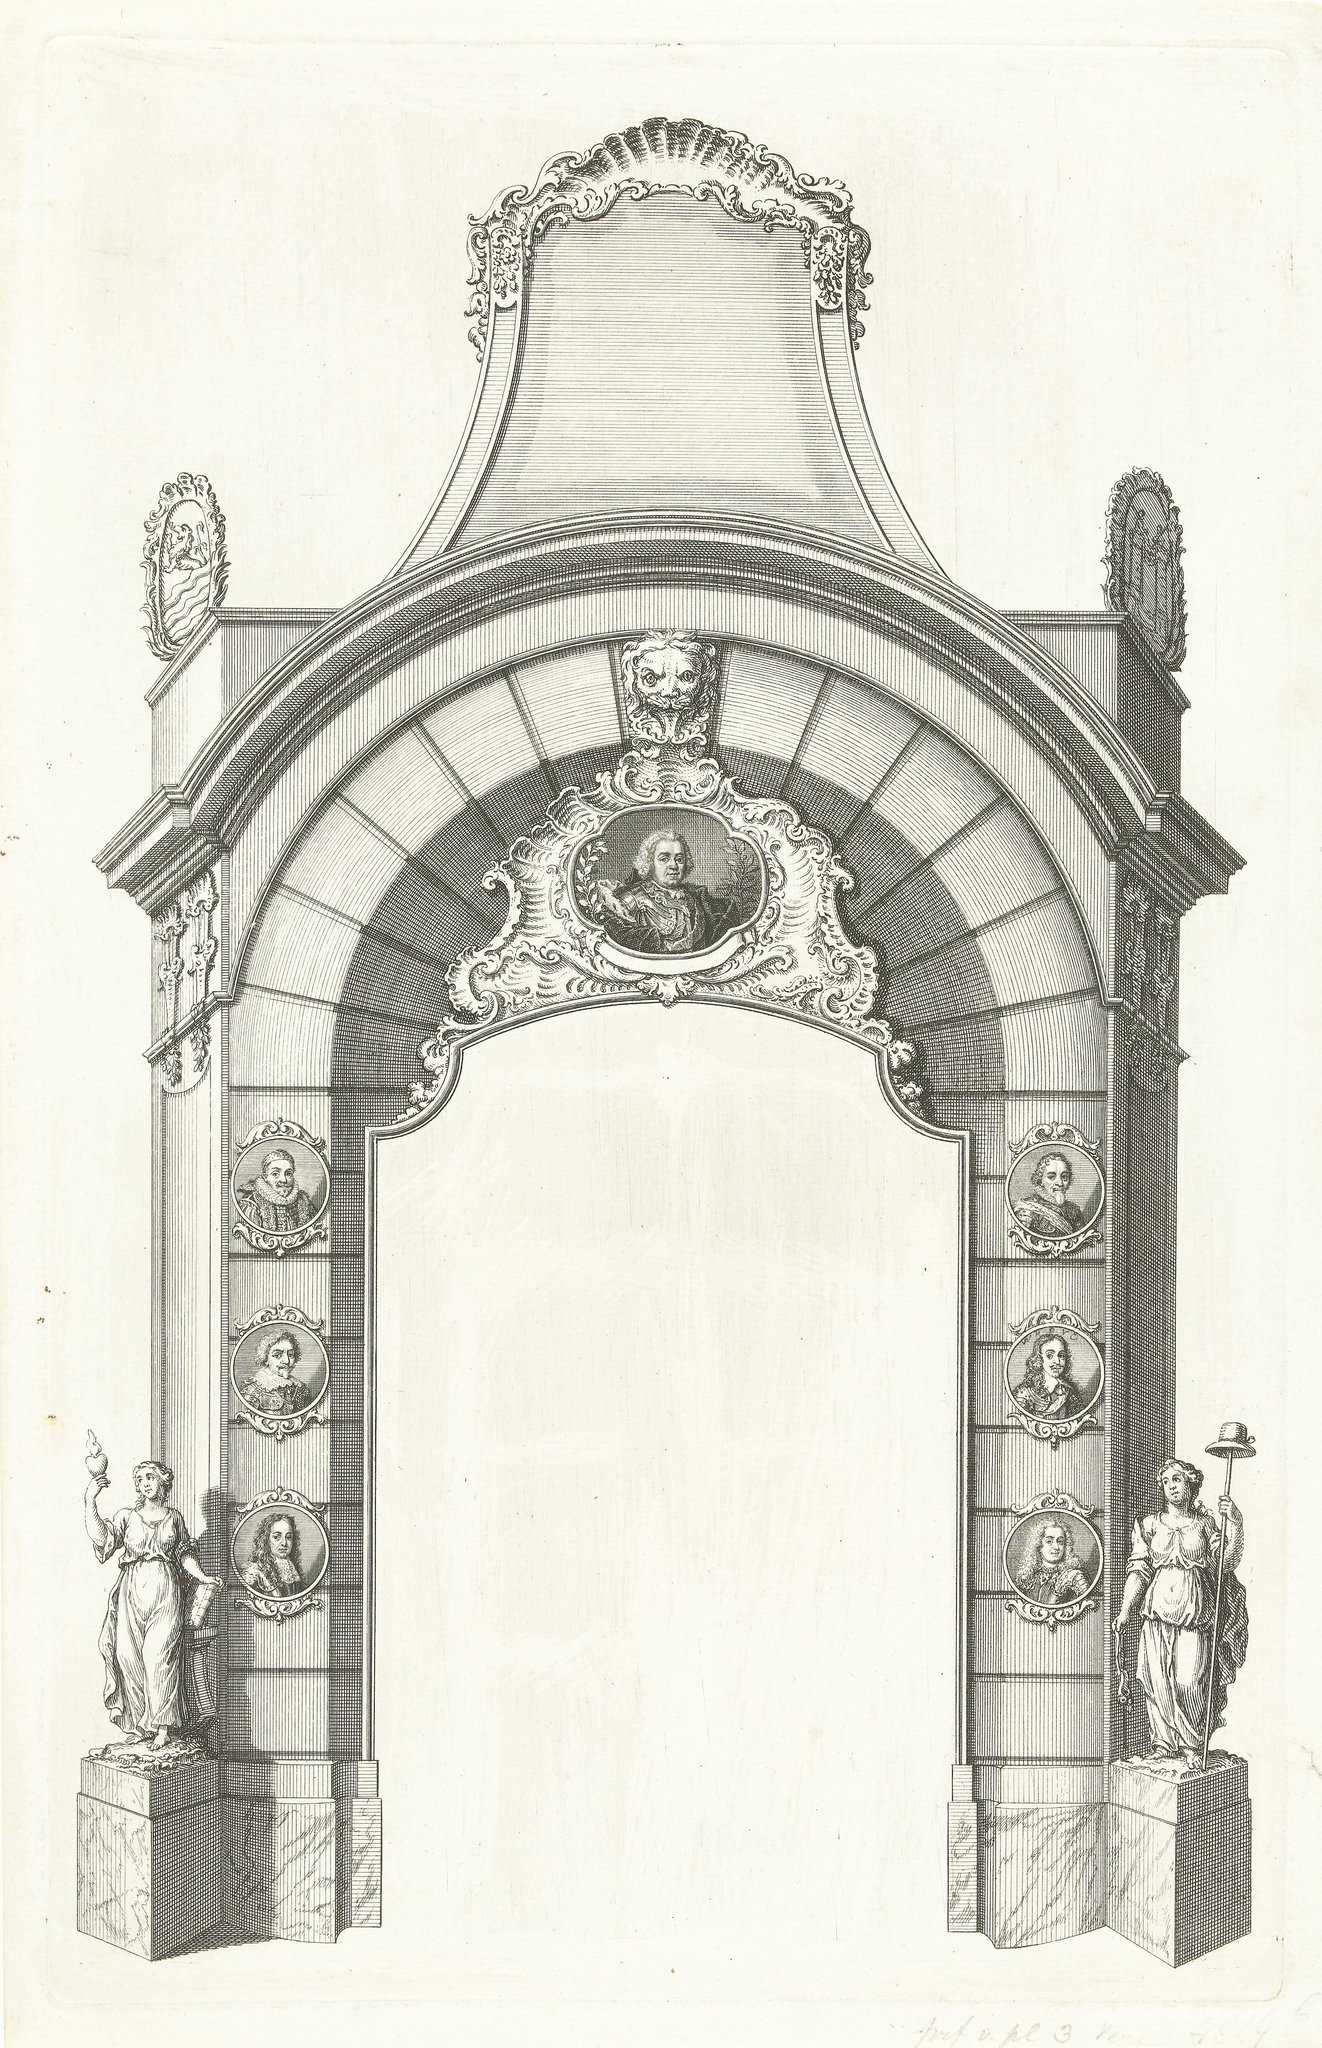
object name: print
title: Erepoort bij de Grote Brug, 1751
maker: caspar jacobsz. philips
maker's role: draughtsman, print maker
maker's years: 1732-1789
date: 1751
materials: paper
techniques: engraving, etching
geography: northern netherlands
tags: the hague, willem iv (prins van oranje-nassau), triumphal arch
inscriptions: collector's mark: Lugt 2228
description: De erepoort geplaatst bij de Grote Brug. Op de boog portretten van stadhouder Willem IV en zijn voorgangers, met standbeelden van Godsdienst en Vrijheid. Onderdeel van de illustraties van de feestelijke inhuldiging van stadhouder Willem IV als markgraaf van Veere op 1 juni 1751.